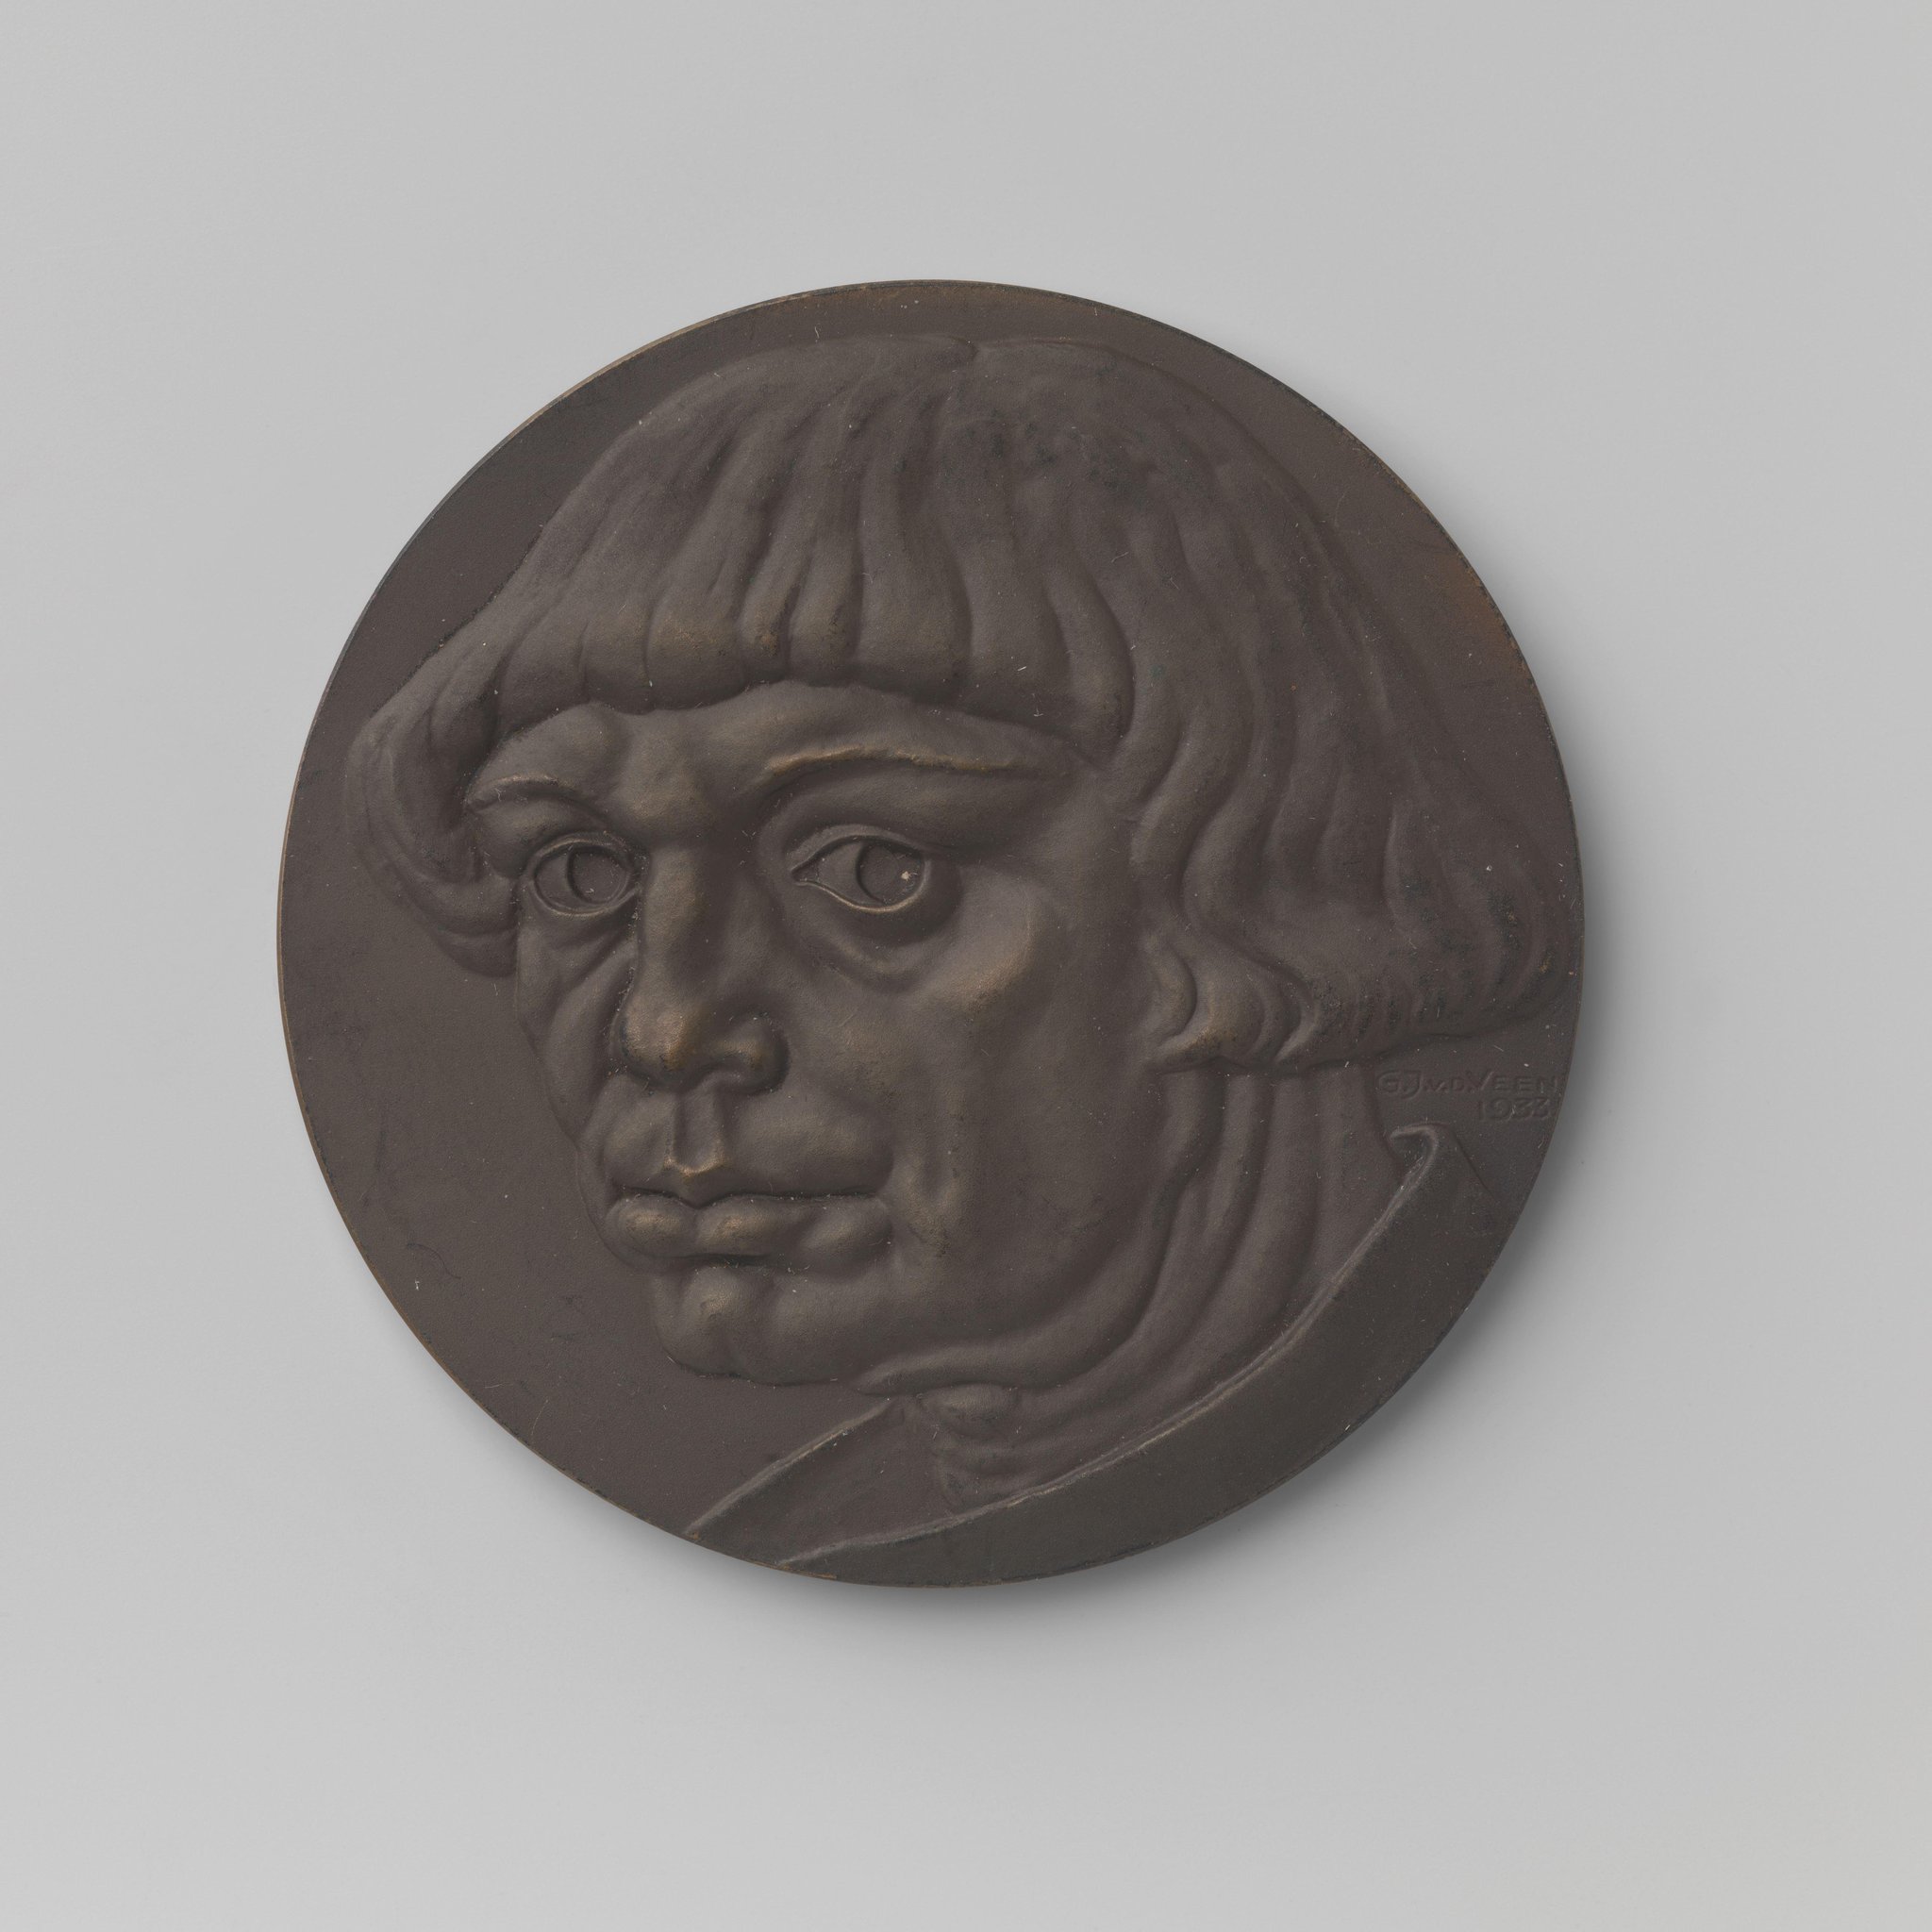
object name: history medal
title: Vierhonderdste overlijdensjaar van Lucas van Leyden (Vereniging voor Penningkunst 1933, eerste penning)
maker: gerrit jan van der veen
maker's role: sculptor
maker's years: 1902-1944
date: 1933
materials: bronze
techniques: striking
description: Bronzen penning, op de voorzijde het portret van Van Leyden half naar links, op de keerzijde klein in het midden een schilder voor zijn werk, van achteren gezien, met omschrift.